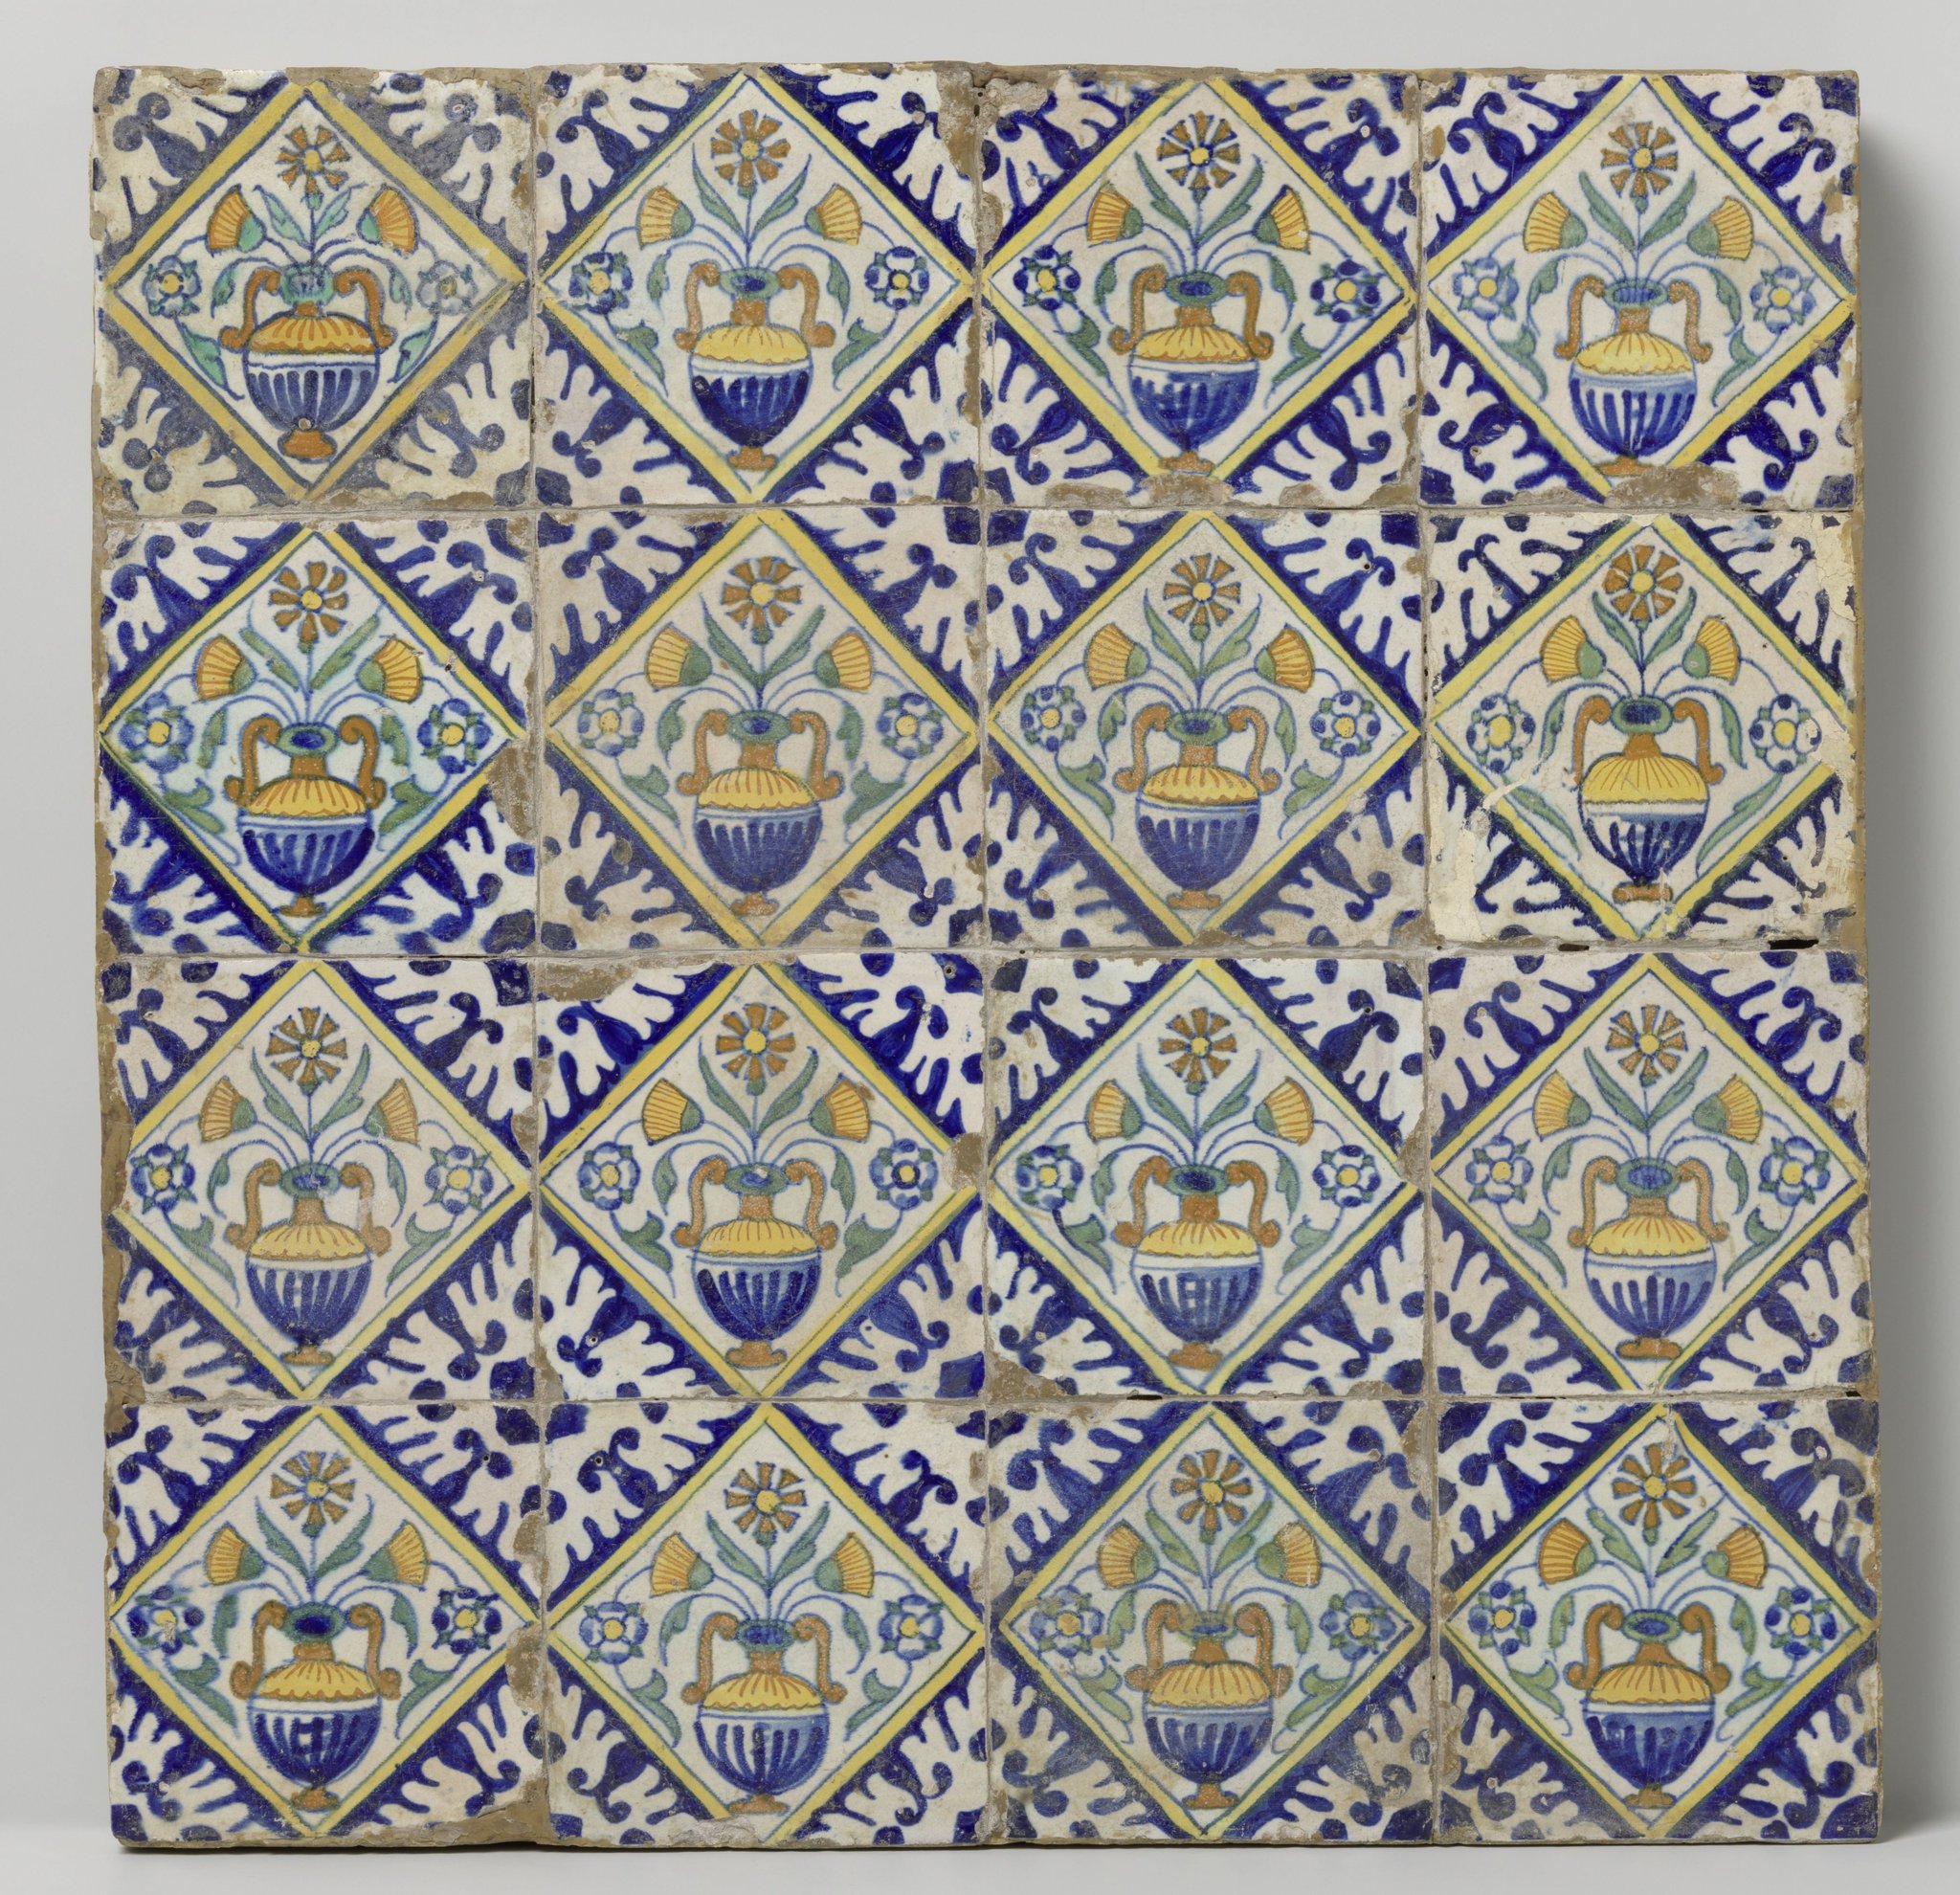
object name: tile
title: Veld van zestien tegels met bloempotten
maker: Anonymous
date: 1580-1625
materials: earthenware, glaze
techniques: maiolica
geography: netherlands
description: Veld van zestien tegels (4 x 4) elk met een veelkleurige (blauw, oranje, groen en geel) bloempot binnen een kwadraat omlijsting. In de hoeken, ornament in vultechniek.